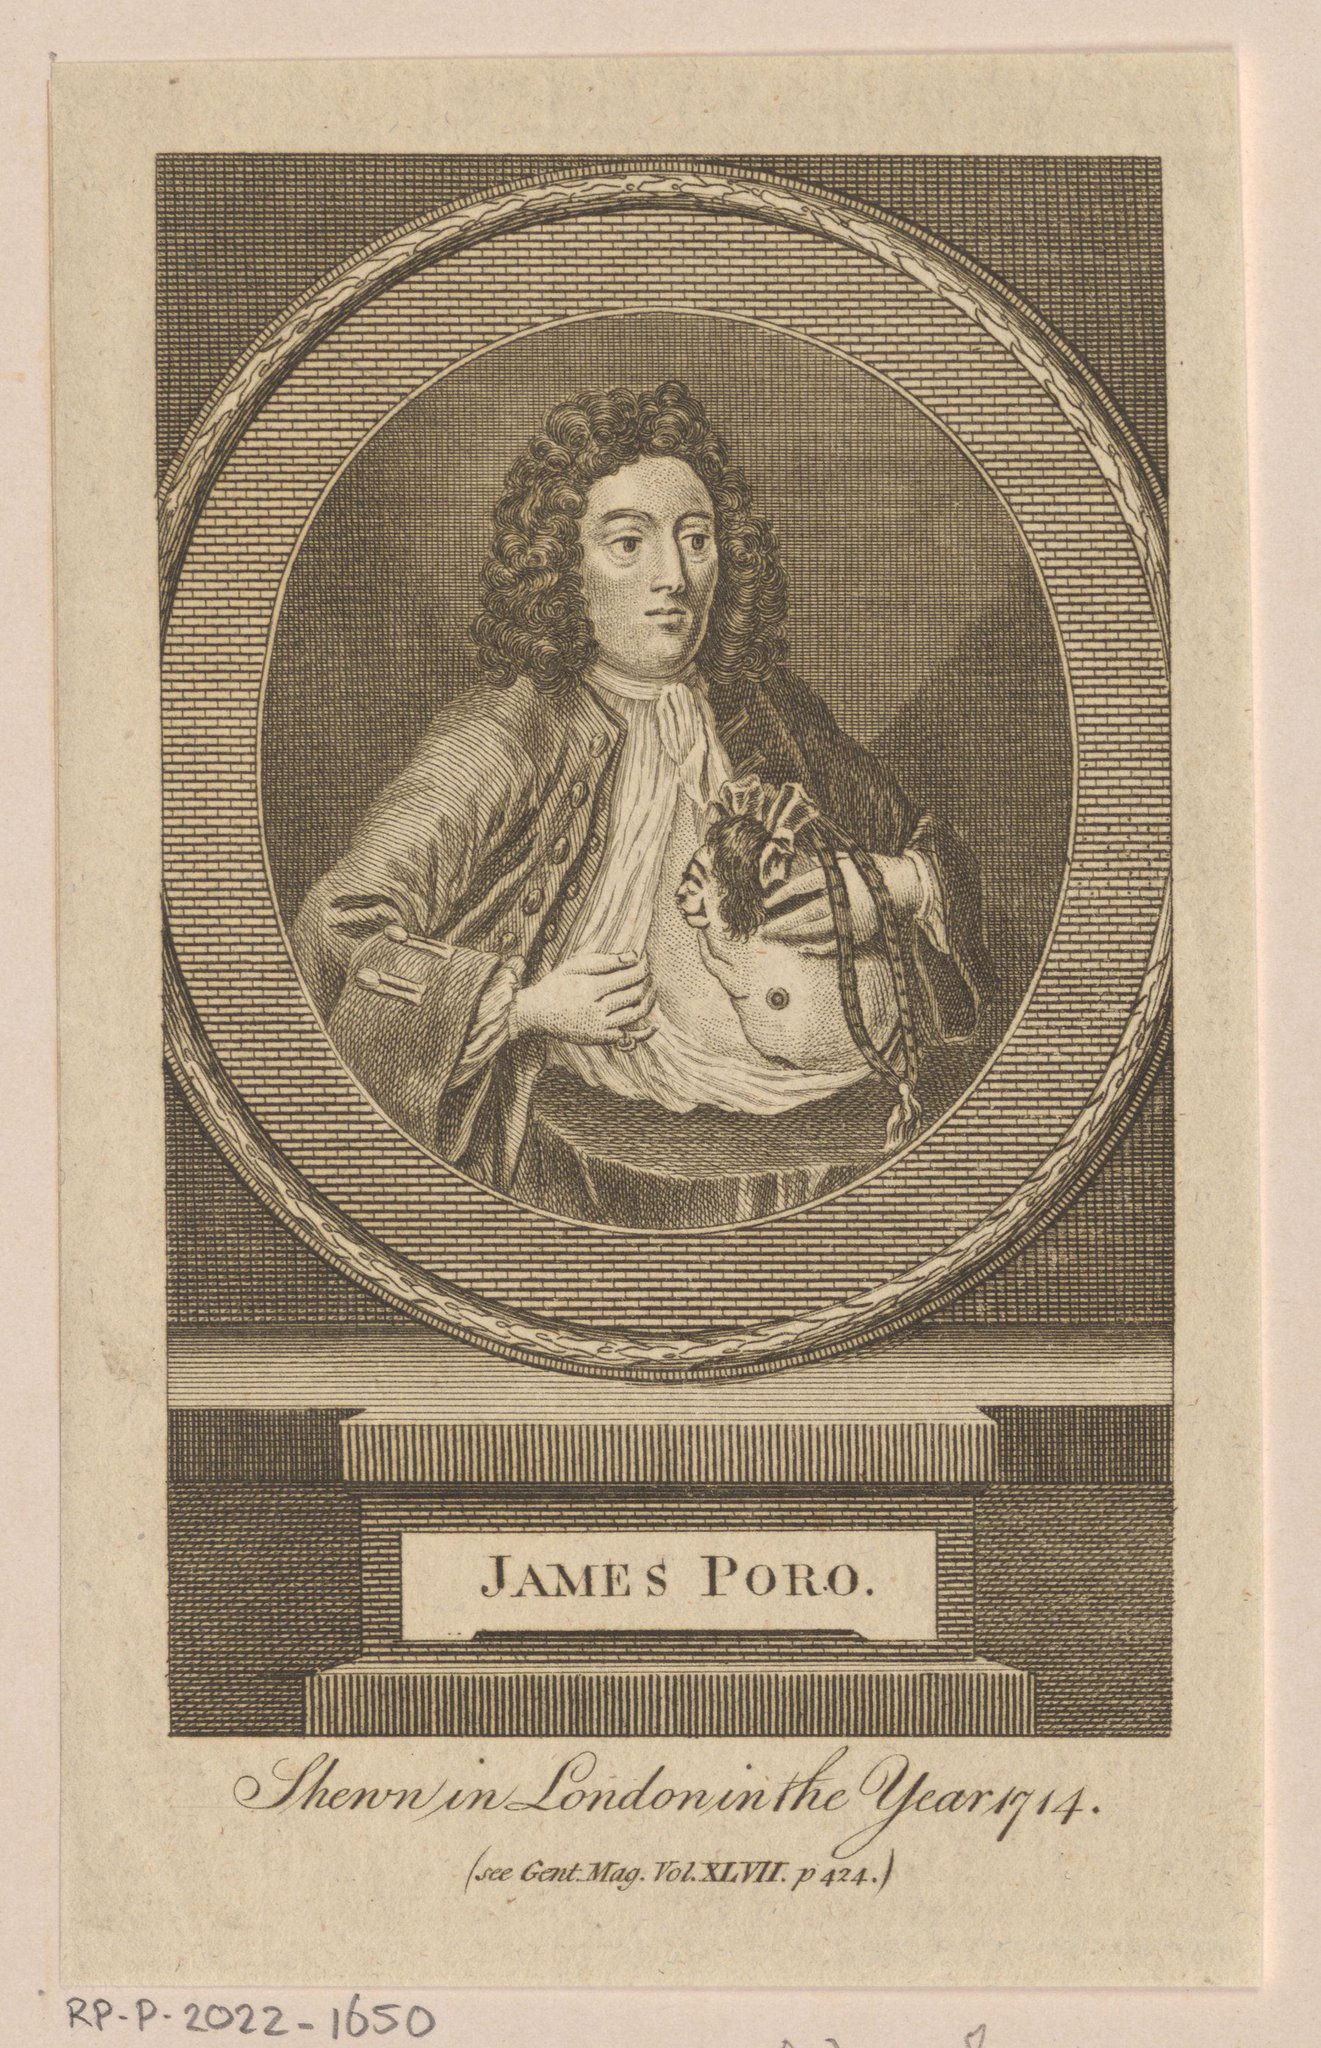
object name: print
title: Portret van James Poro en Matthew Poro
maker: Anonymous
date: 1777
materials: paper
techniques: engraving, etching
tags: historical persons, siamese twins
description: Prent waarschijnlijk uit: The Gentleman's Magazine 47 (1777), januari 1777.